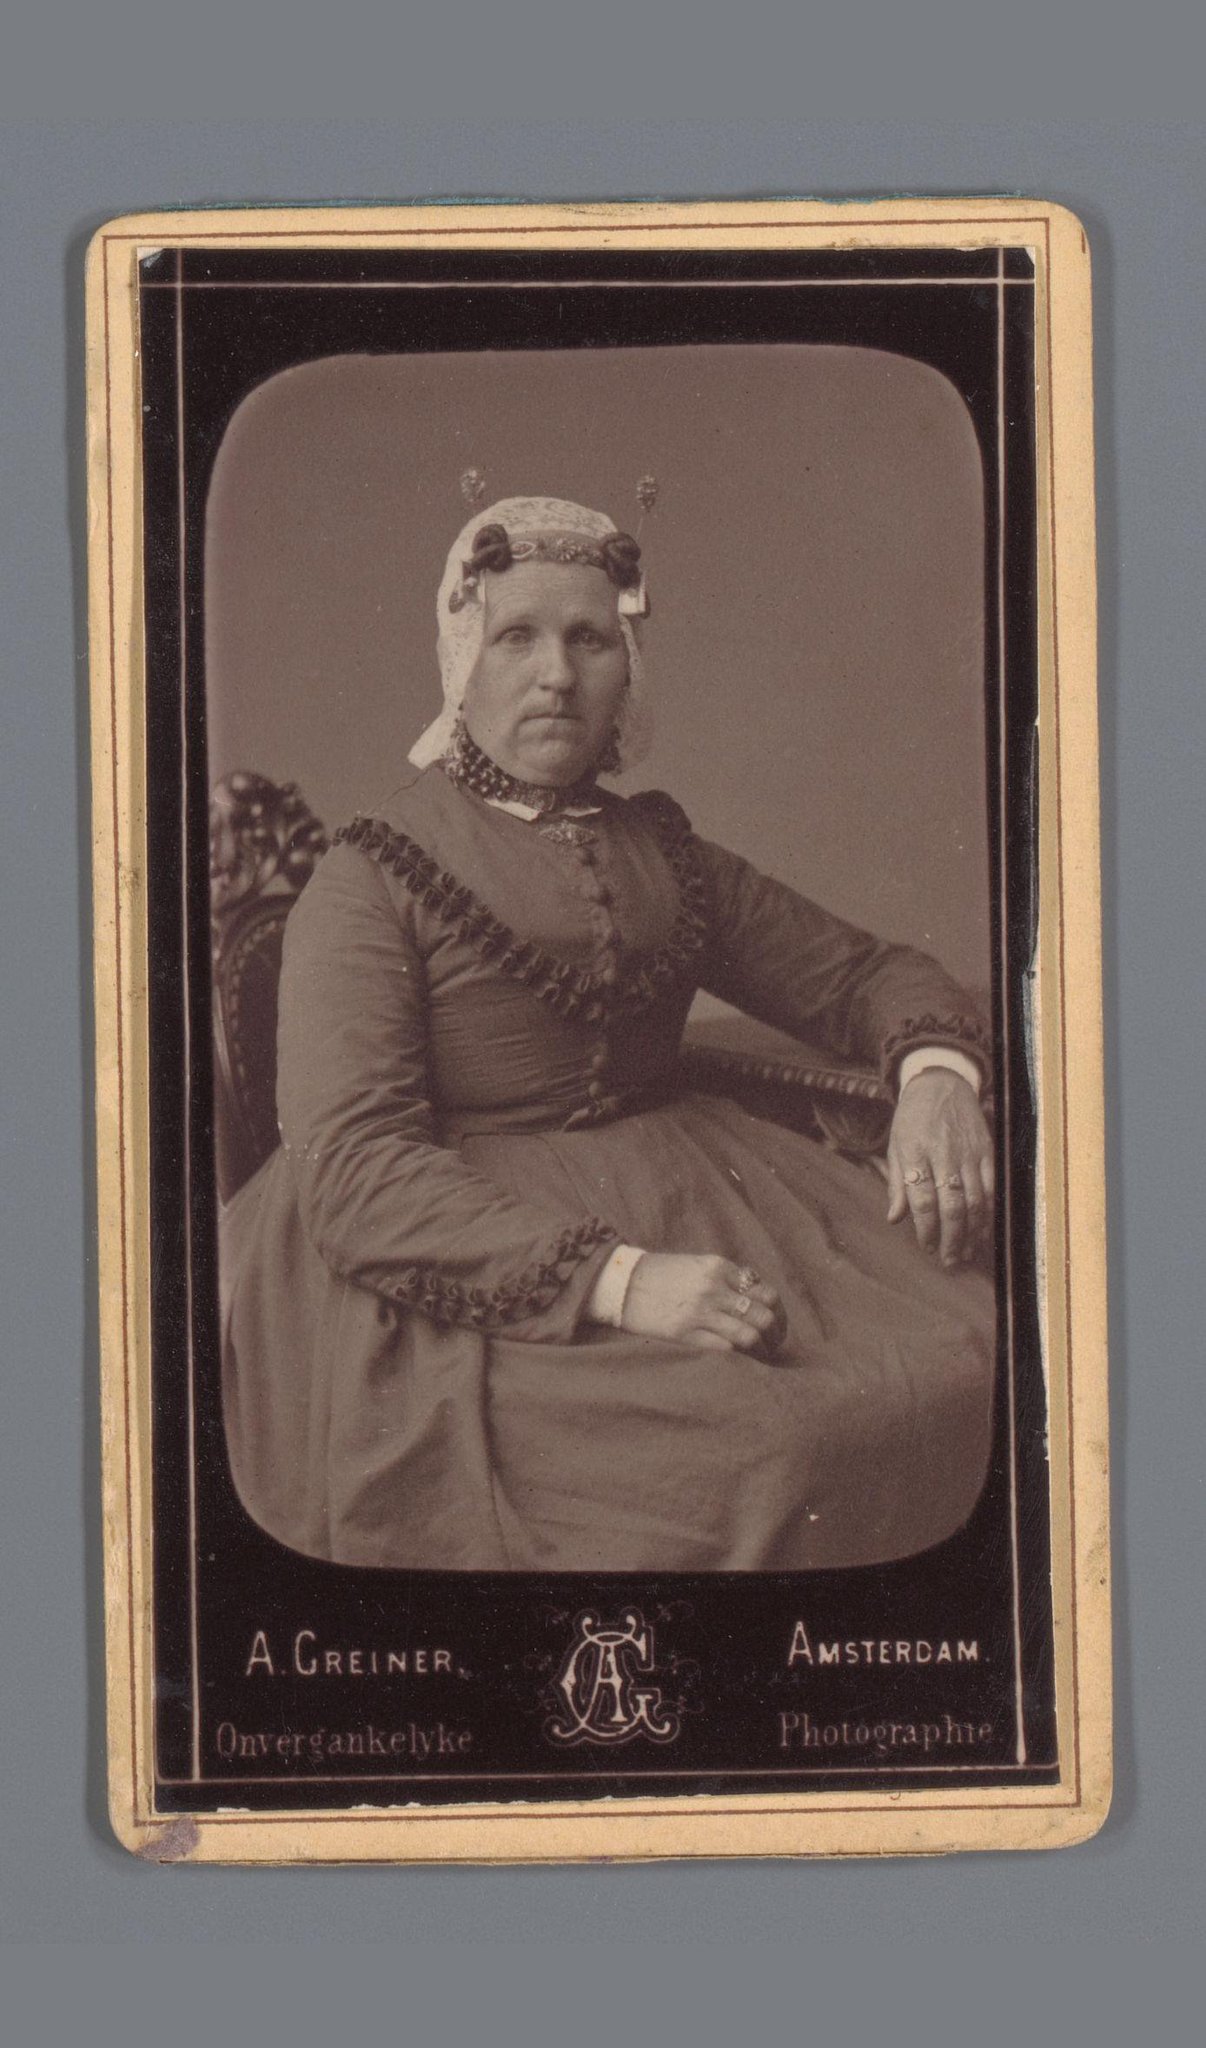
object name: carte de visite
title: Portret van een onbekende vrouw met muts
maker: albert greiner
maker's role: fotograaf, fotostudio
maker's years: 1833-1890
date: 1874-1887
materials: cardboard, photographic support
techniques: carbon print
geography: amsterdam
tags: sitting figure, historical persons - bb - woman, head-gear: cap, folk costume, regional costume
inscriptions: inscription: ‘onveranderlijke Kooldruk’, inscription: ‘AG/ A. GREINER/ Photograf/ AMSTERDAM/ NIEUWENDIJK L. 89.’